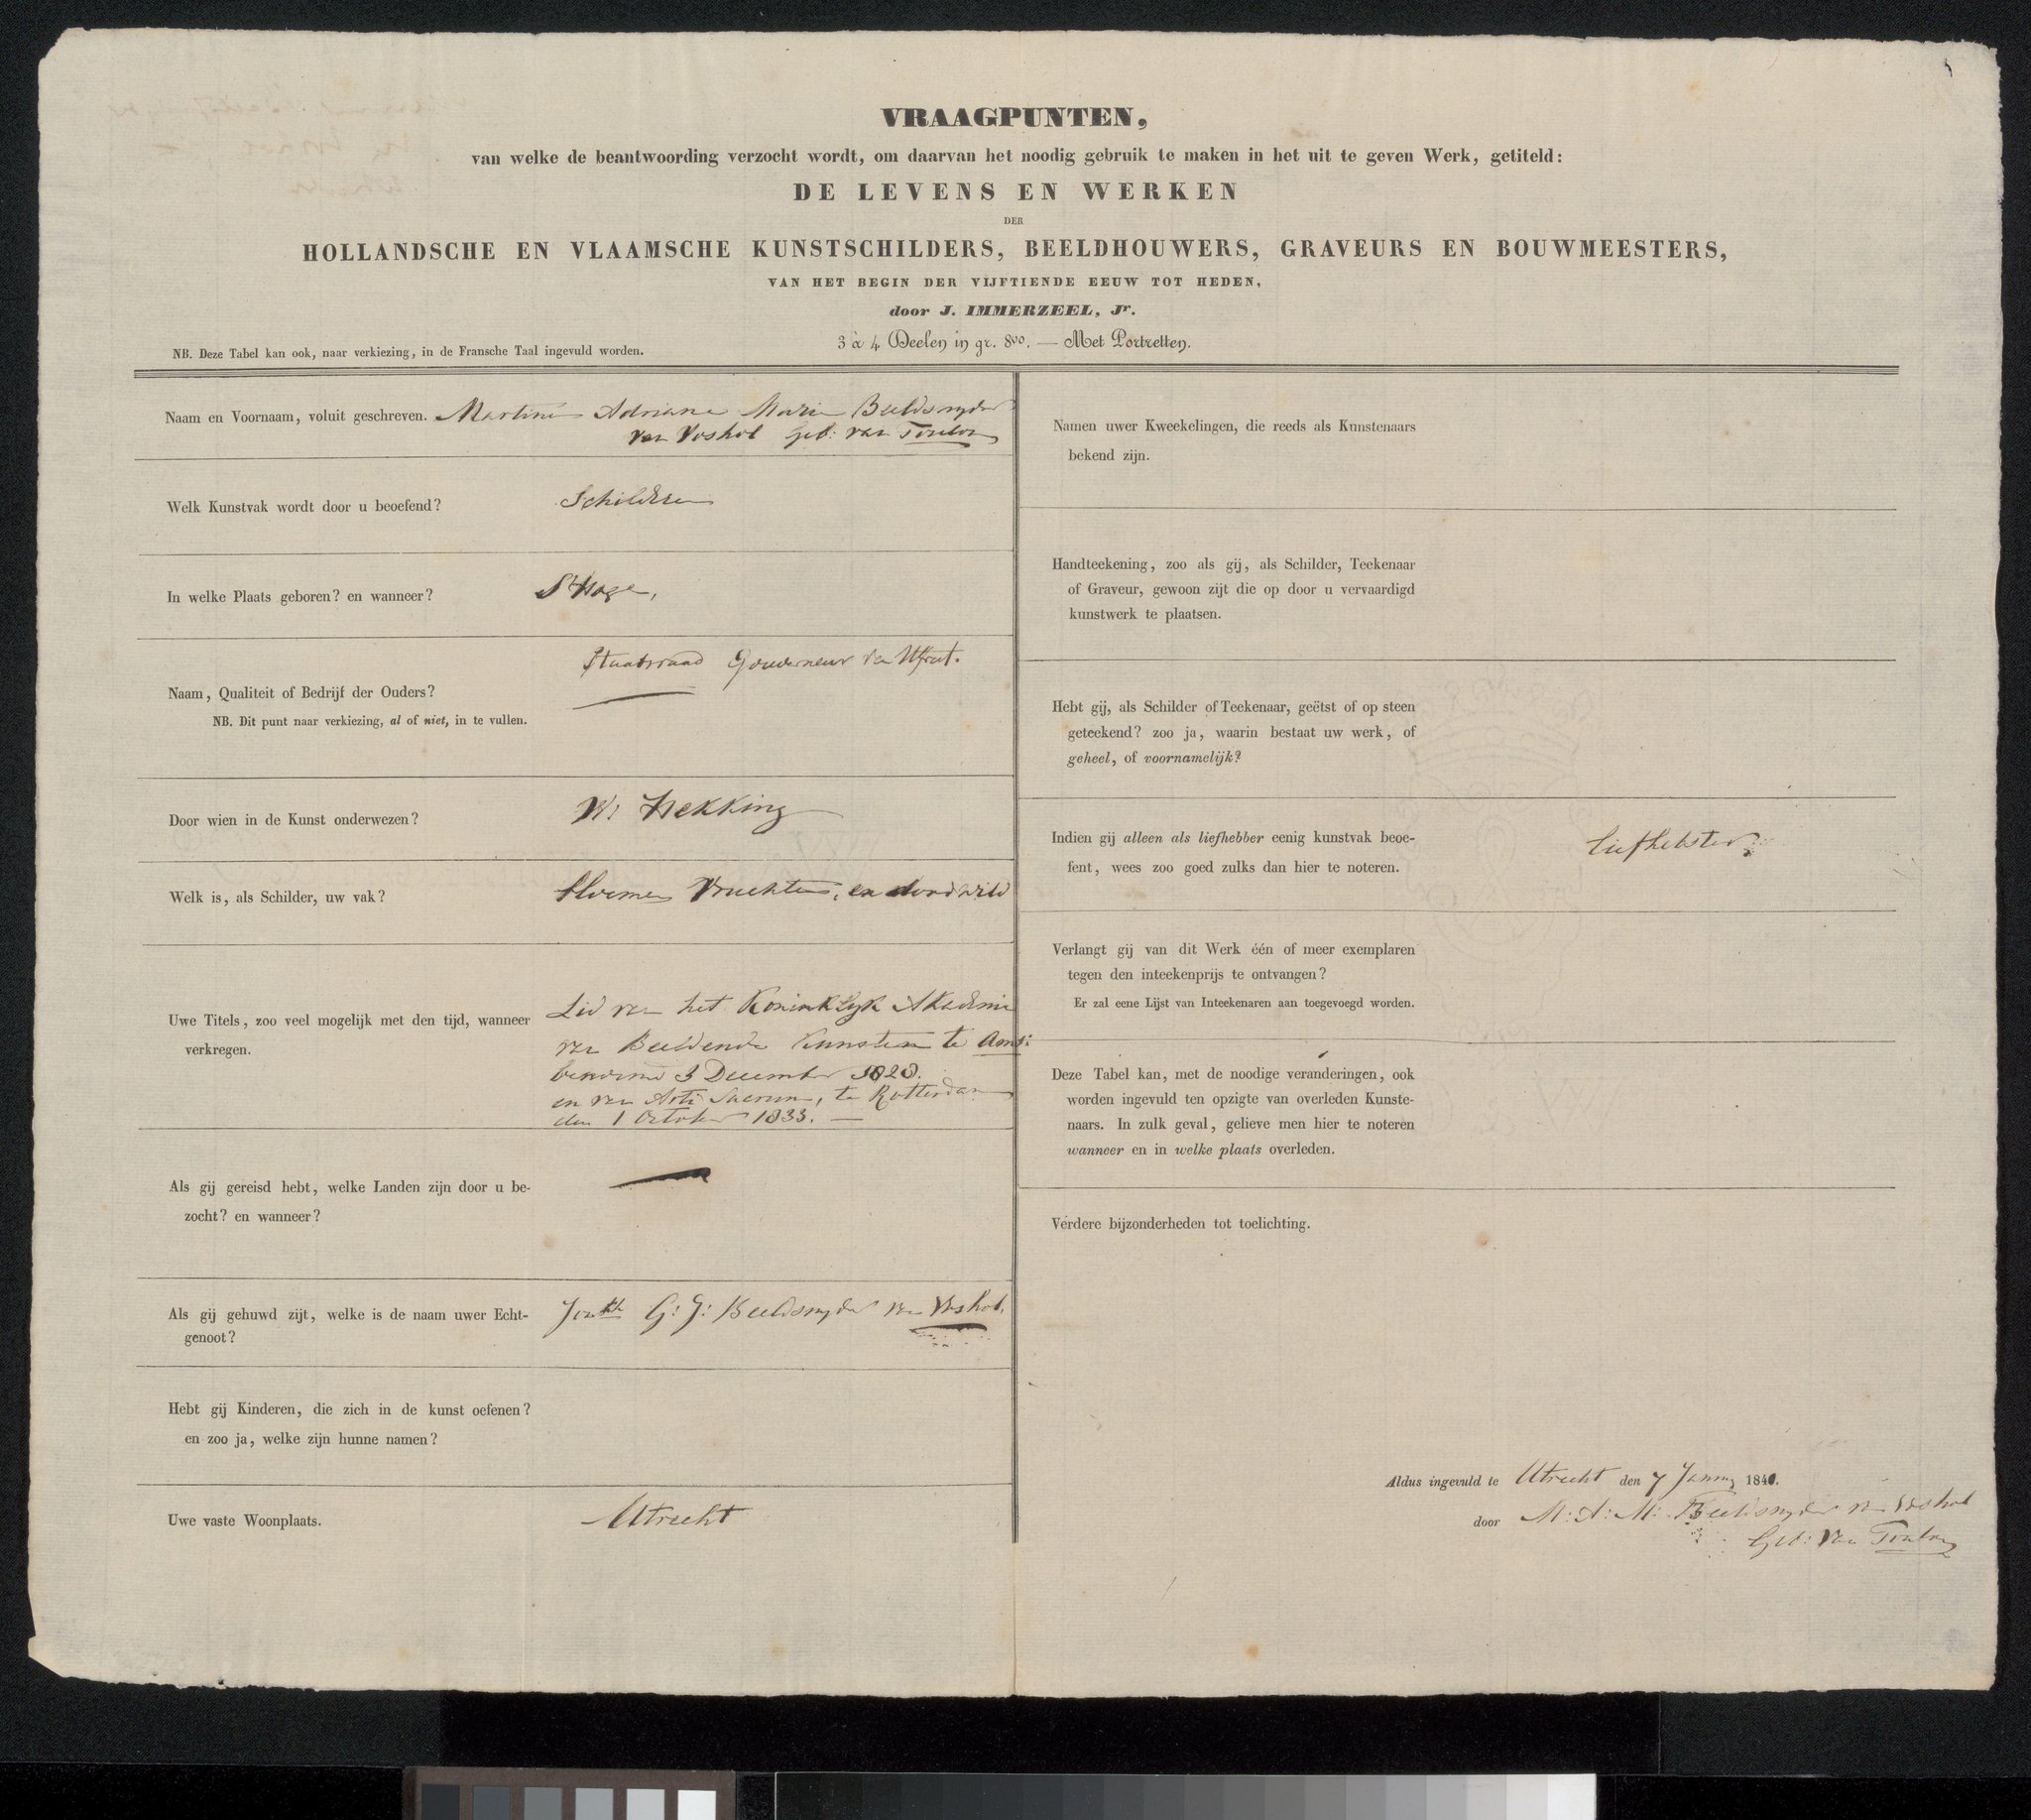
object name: questionnaire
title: Enquêteformulier ingevuld door Martina Adriana Maria van Toulon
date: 1841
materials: ink, paper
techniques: pen, printing, writing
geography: utrecht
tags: the hague, utrecht, martina adriana maria van toulon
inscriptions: watermark, inscription: ‘Vraagpunten,/ van welke de beantwoording verzocht wordt, om daarvan het noodig gebruik te maken in het uit te geven Werk, getiteld: De levens en werken/ der Hollandsche en Vlaamsche kunstschilders, beeldhouwers,/ graveurs en bouwmeesters, van het begin der vijftiende eeuw tot heden/ door J. Immerzeel, Jr.’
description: Opgenomen in: Immerzeel, J. Jr., De levens en werken der Hollandsche en Vlaamsche kunstschilders, beeldhouwers, graveurs en bouwmeesters, van het begin der vijftiende eeuw tot heden, Amsterdam: J.C. van Kesteren, 1842-1843.